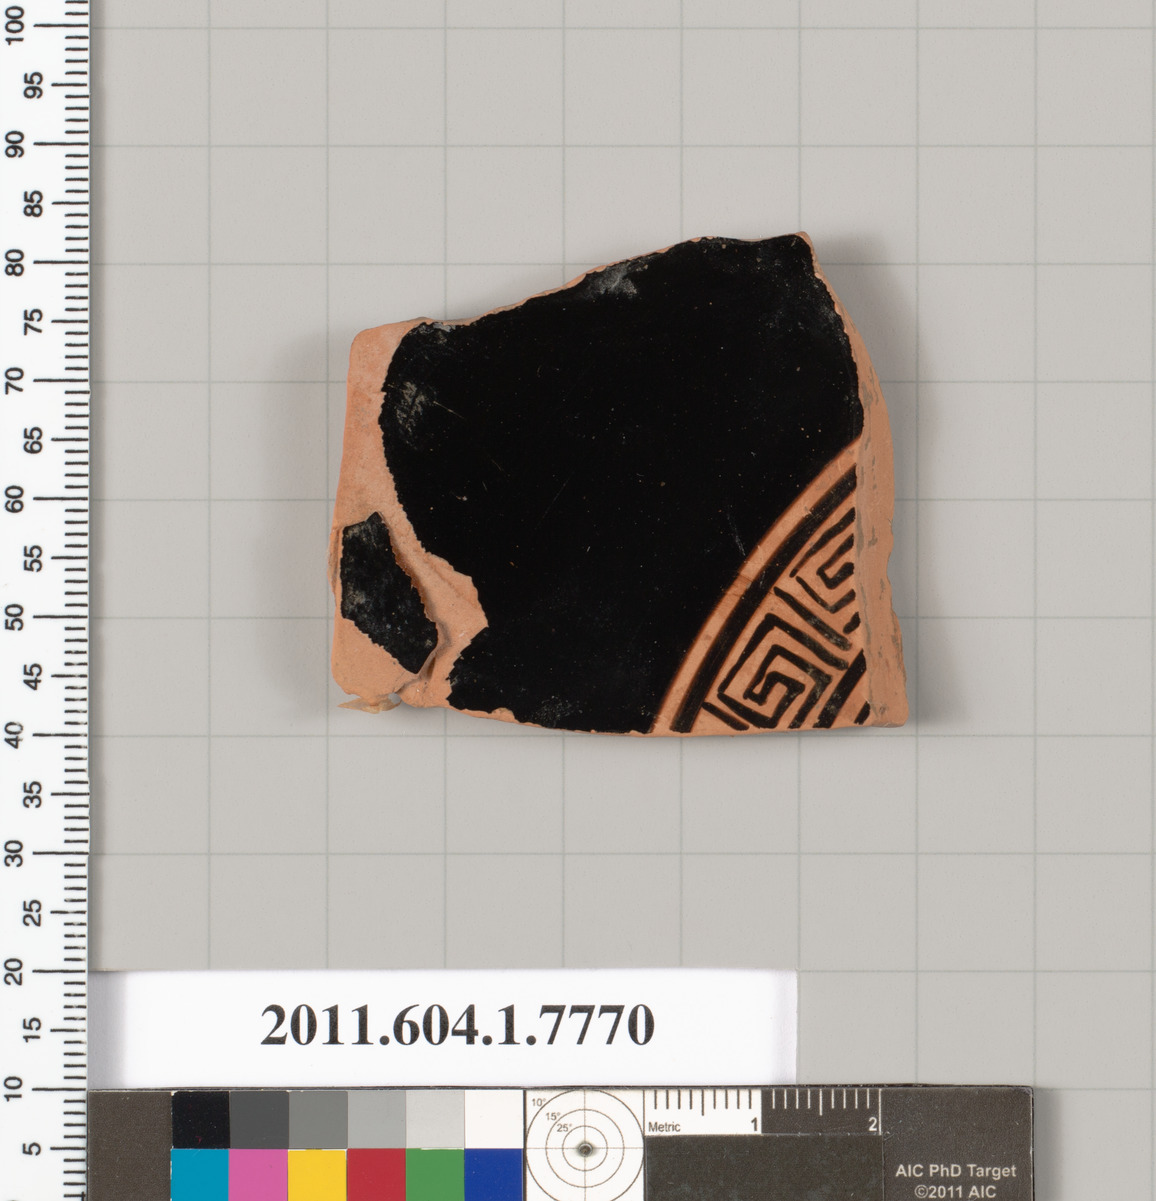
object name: kylix fragment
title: Terracotta fragment of a kylix (drinking cup)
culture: greek, attic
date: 460-450 BCE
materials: terracotta